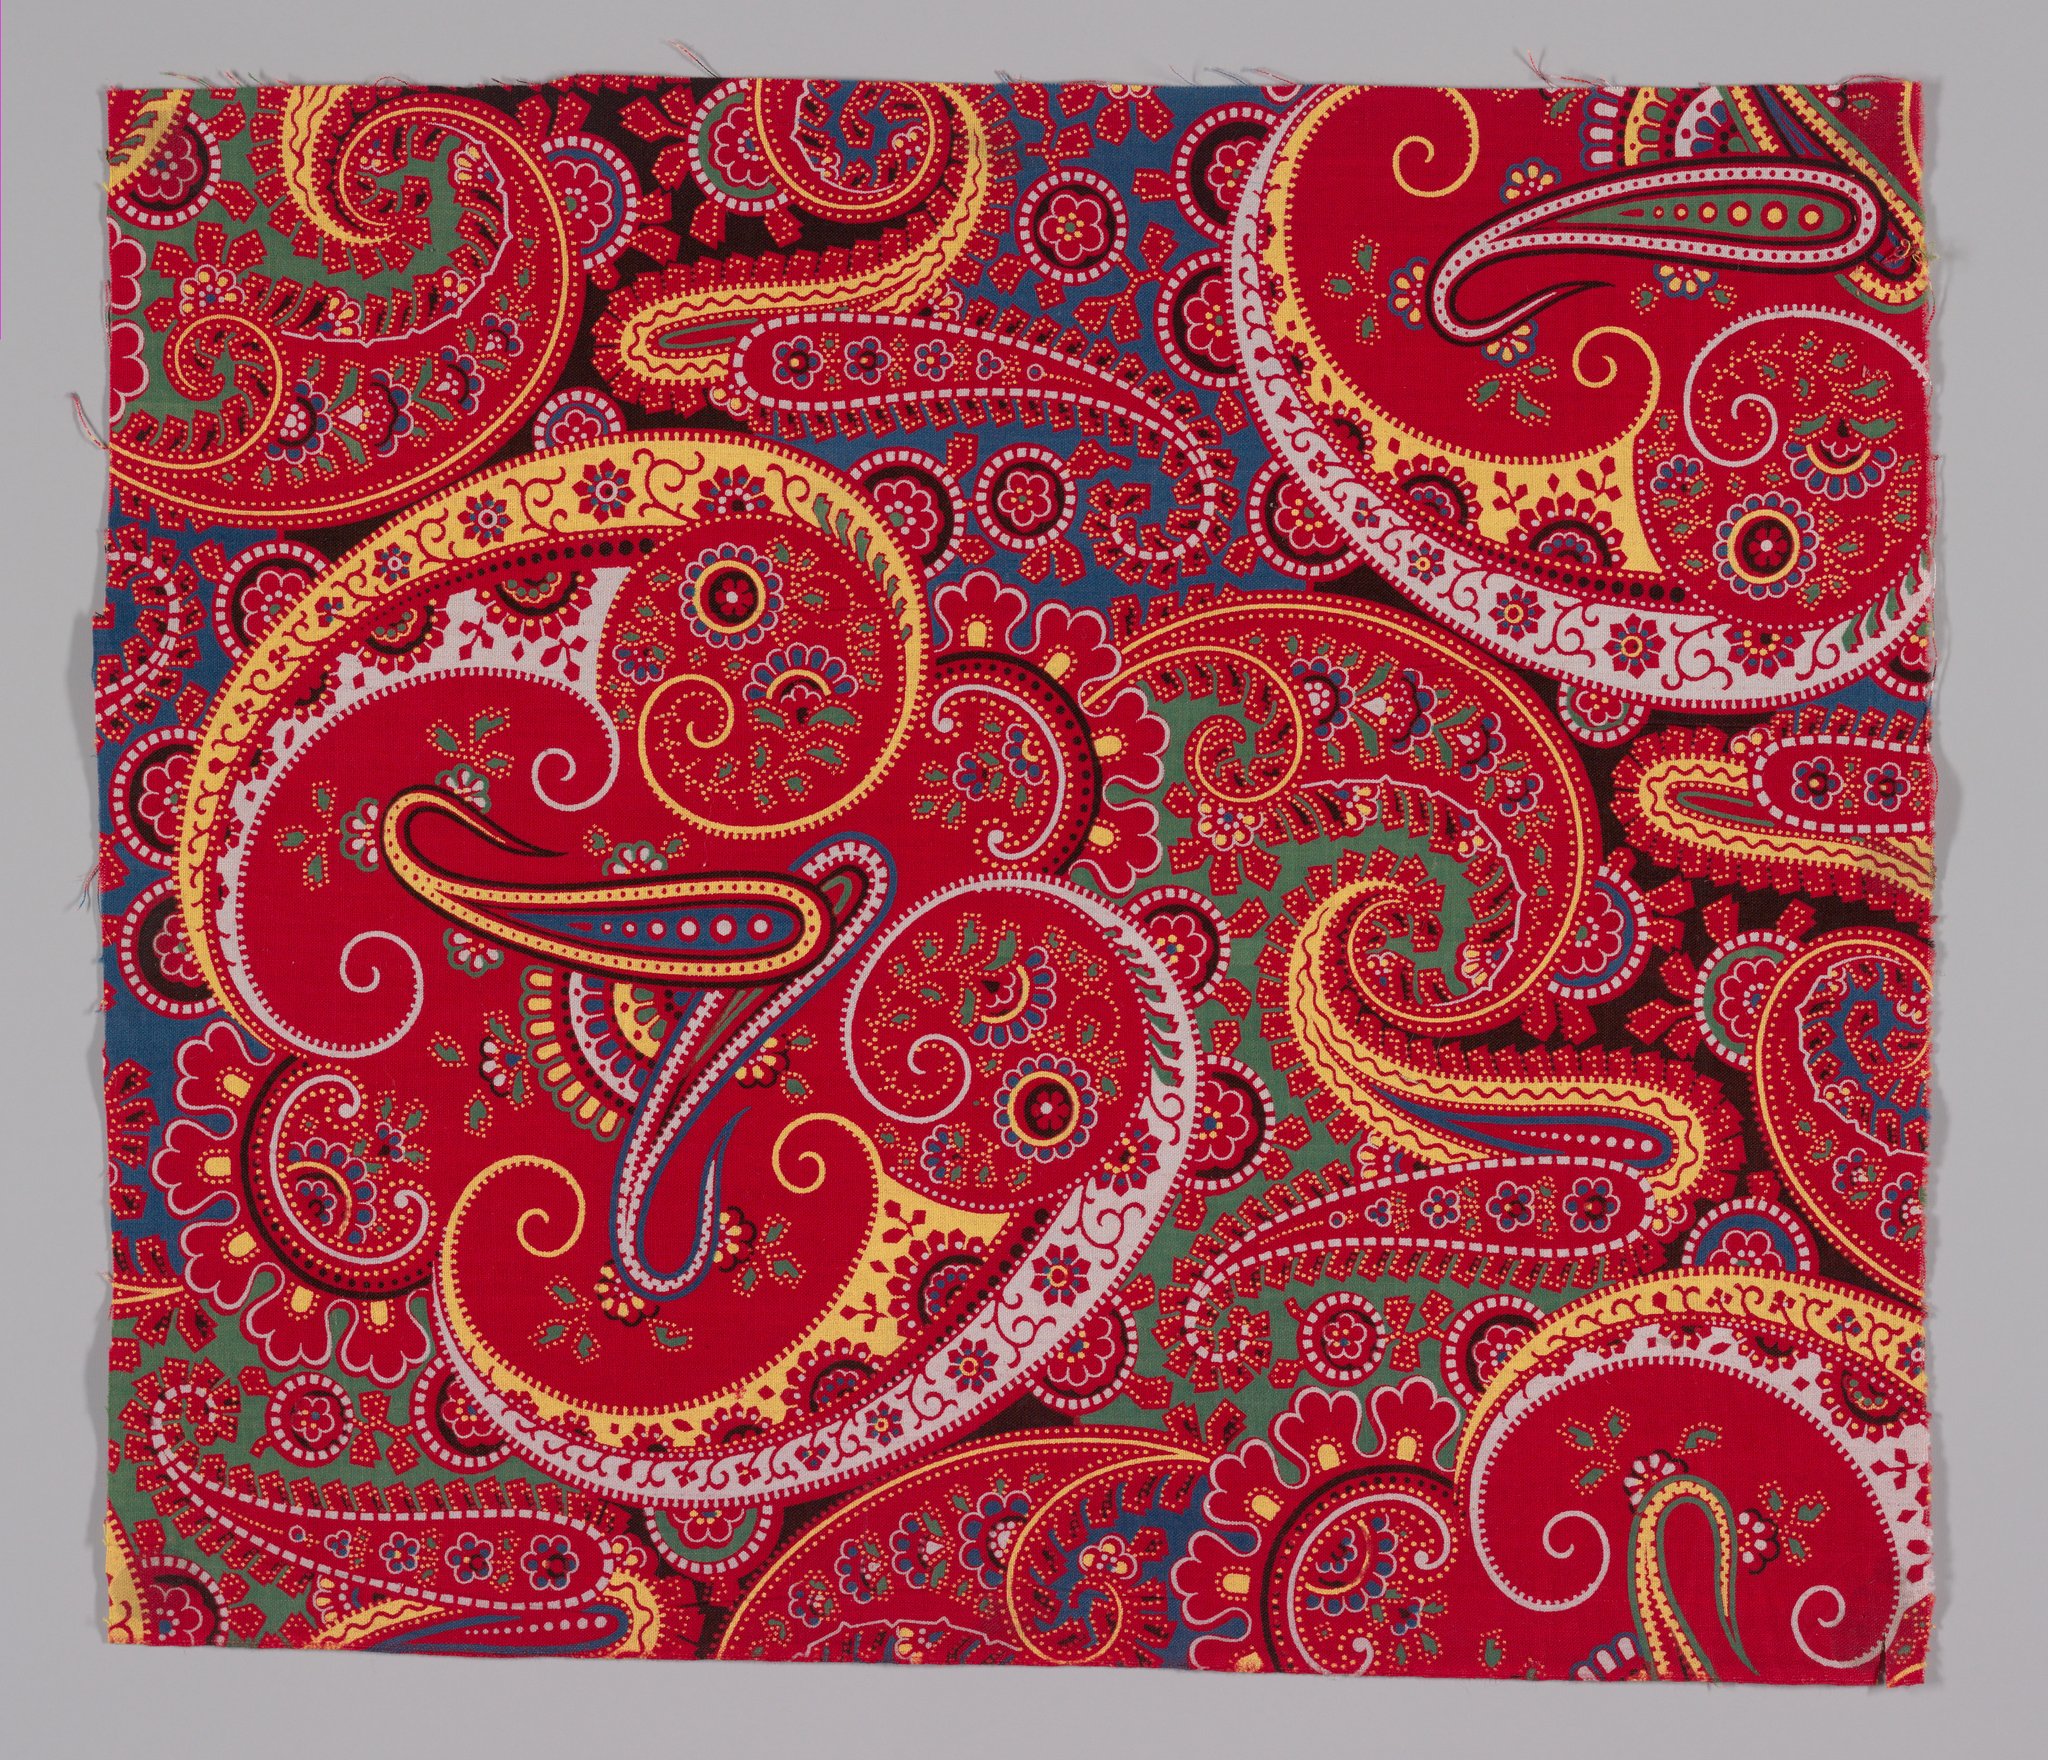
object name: piece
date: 1867-1900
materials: cotton